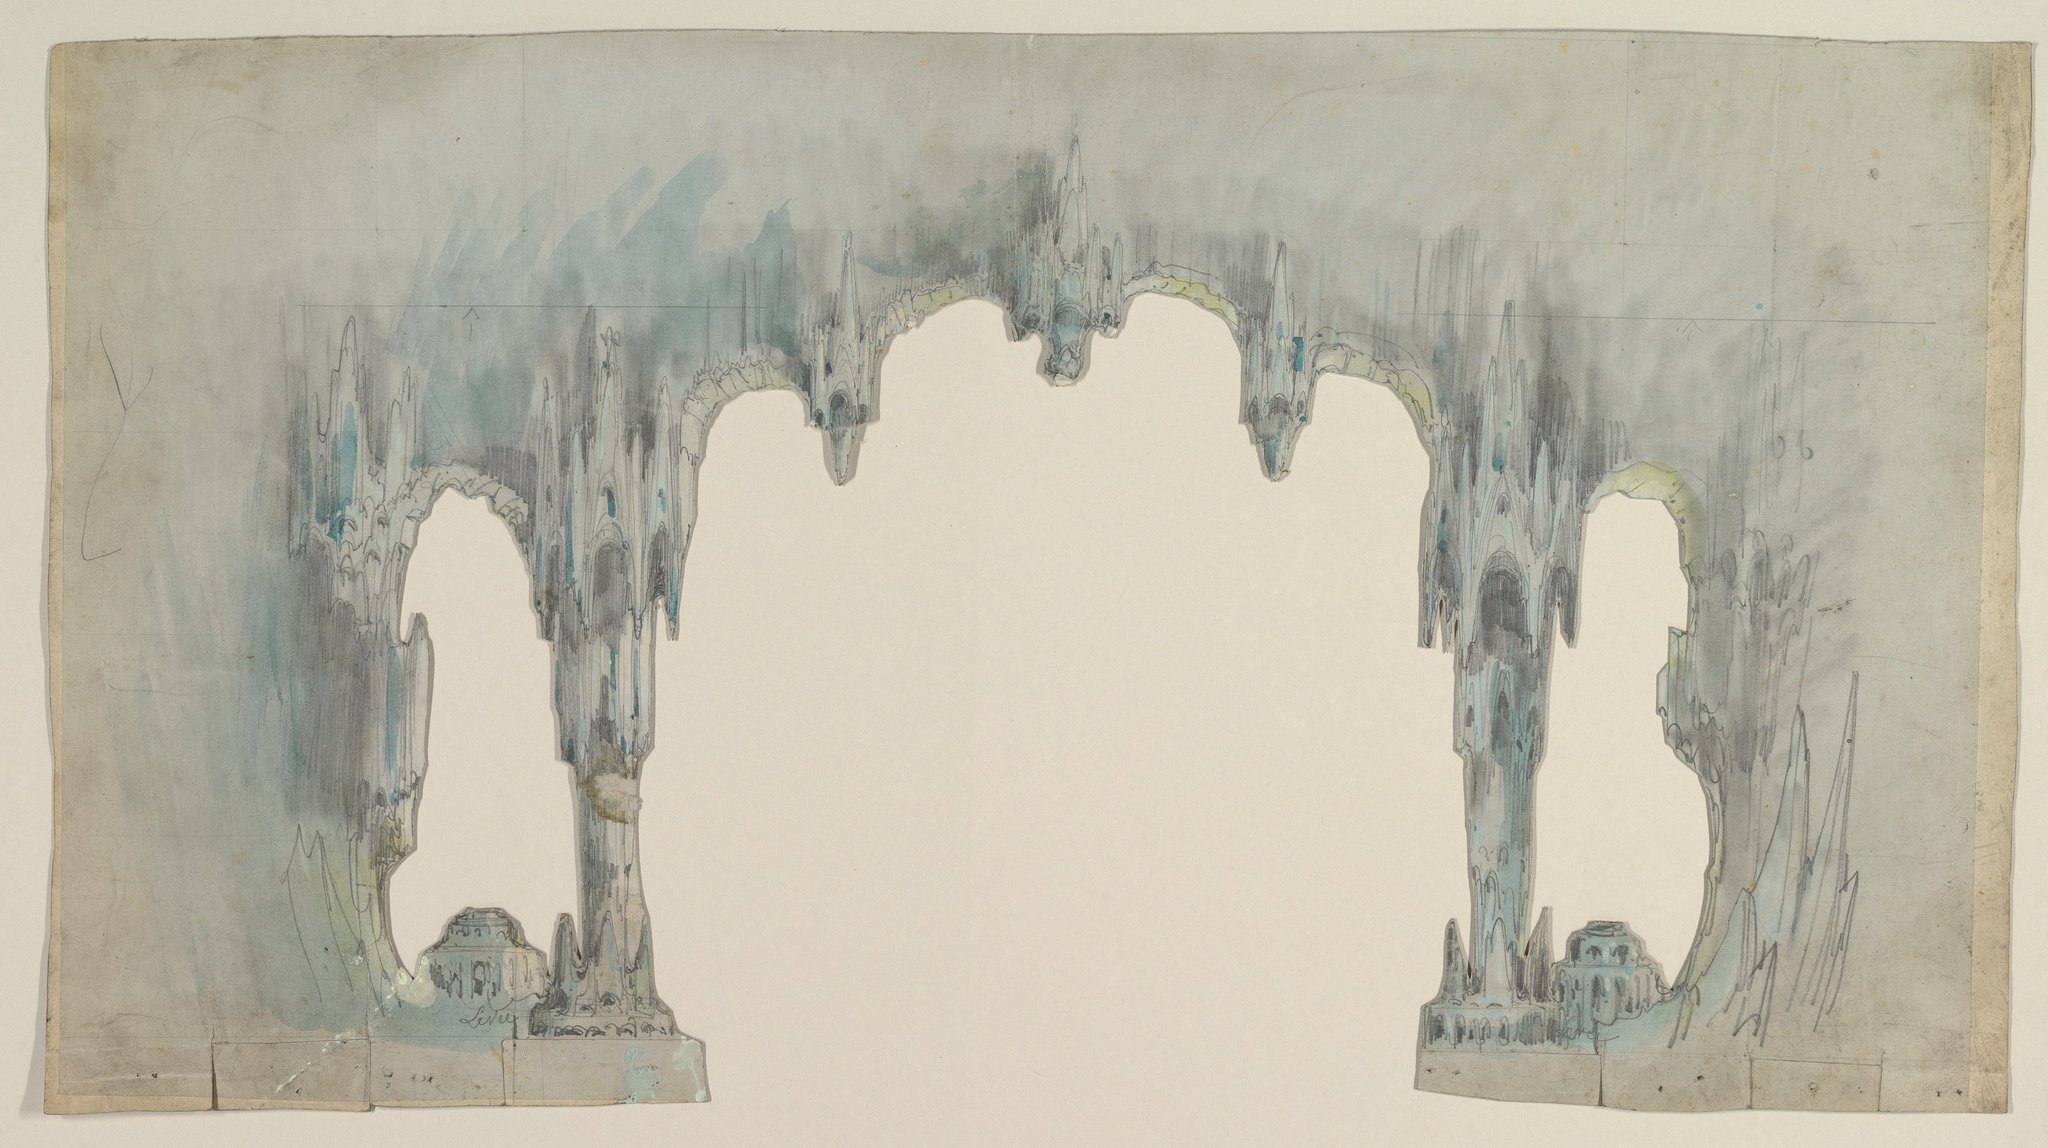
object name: drawing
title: Design for a Stage Set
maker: eugène cicéri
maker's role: artist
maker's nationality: french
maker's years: 1813-1890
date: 1830-1890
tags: stage design